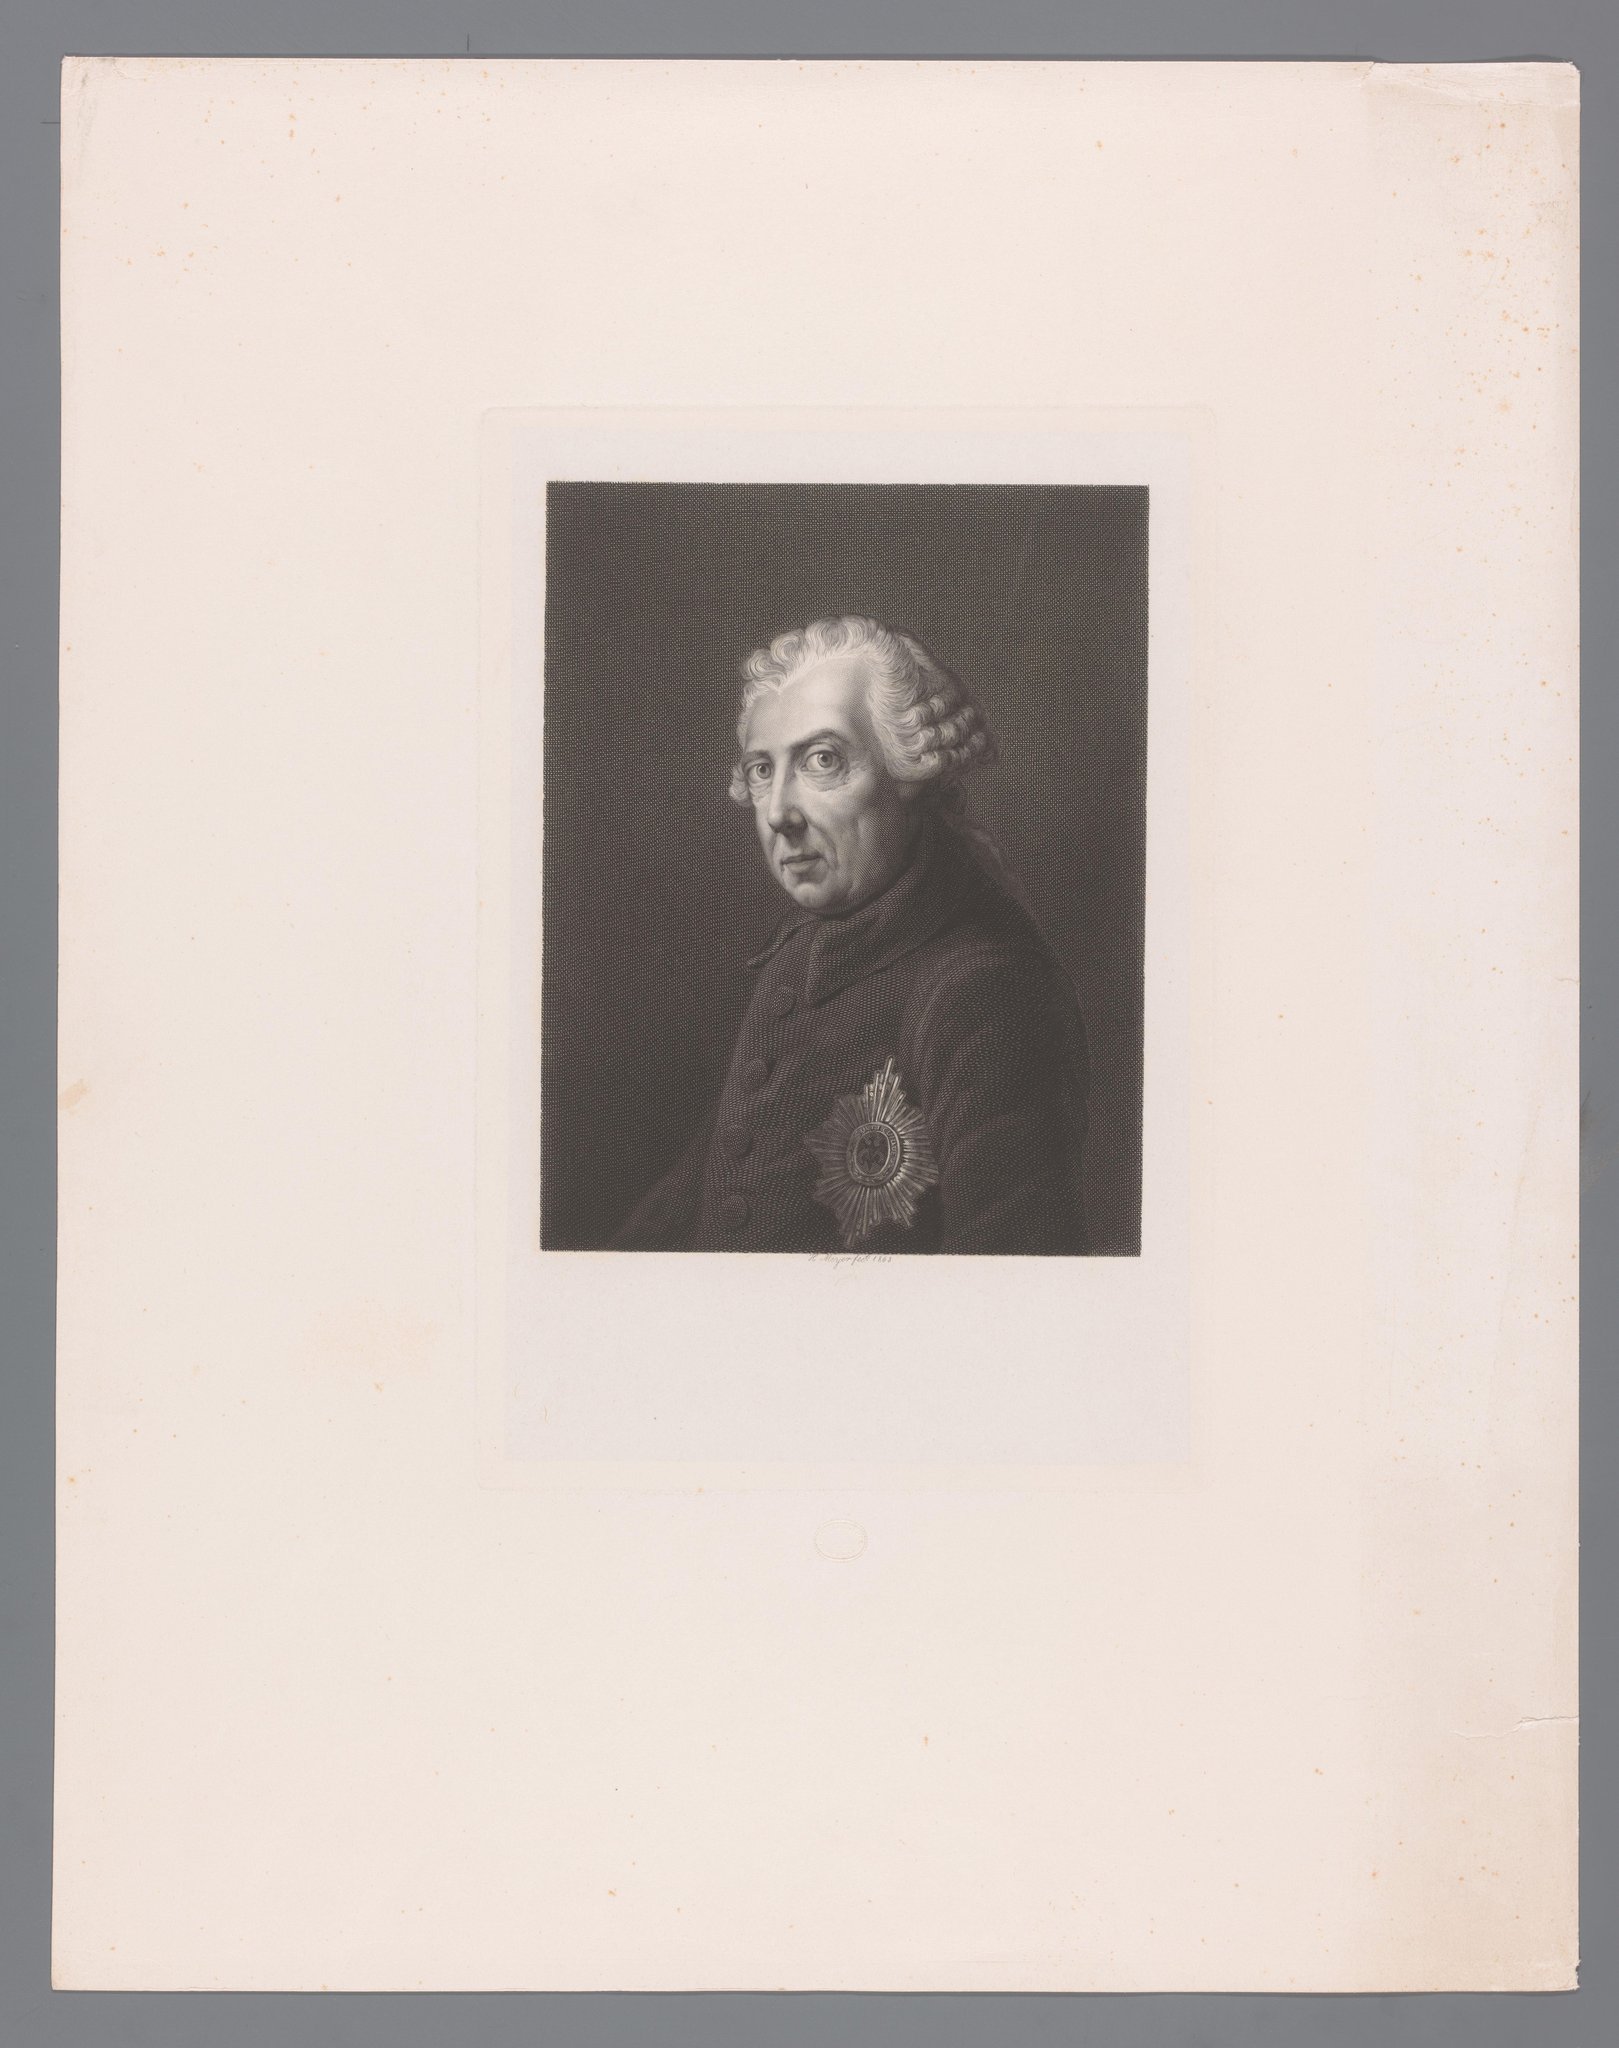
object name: print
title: Portret van een onbekende man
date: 1812-1877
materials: paper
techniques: engraving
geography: berlin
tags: knighthood order (with name) - insignia of a knighthood order, e.g.: badge, chain (with name of order), historical persons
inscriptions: collector's mark: Lugt 12